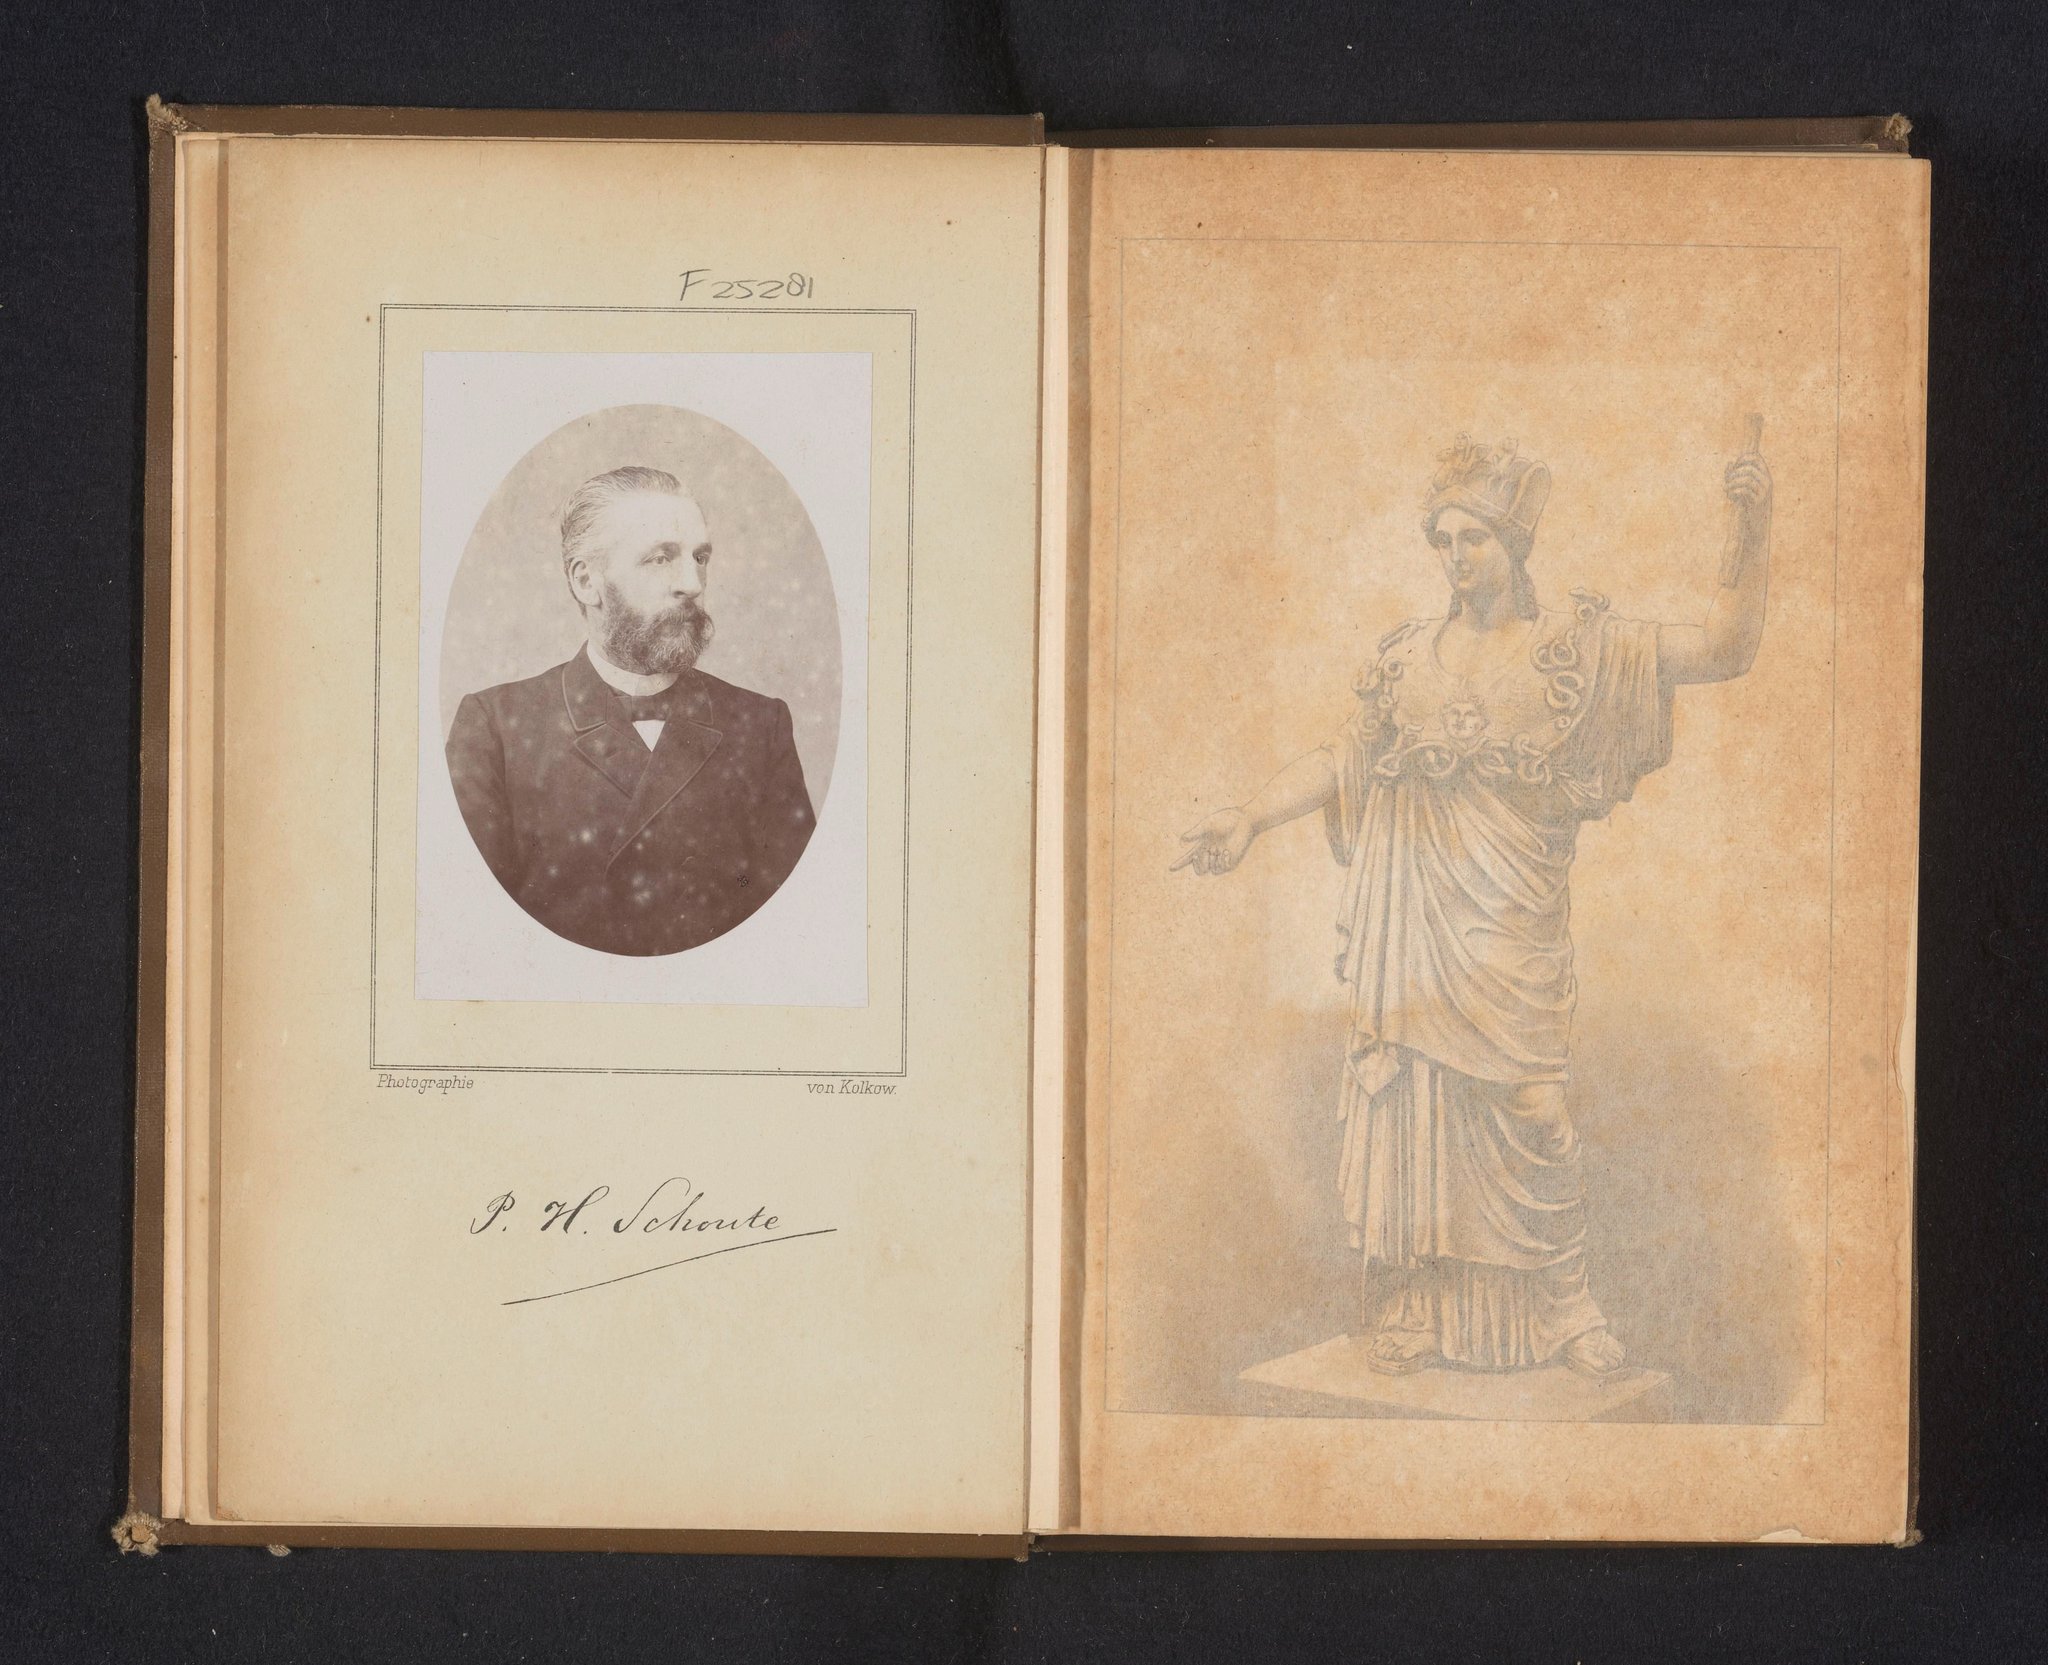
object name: page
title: Portret van Pieter Hendrik Schoute, hoogleraar wis- en natuurkunde in Groningen en rector magnificus van 1892 tot 1893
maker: friedrich julius von kolkow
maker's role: fotograaf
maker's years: 1839-1914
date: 1888-1893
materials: photographic support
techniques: collodion silver print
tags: historical persons, professor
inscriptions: name: ‘P. H. Schoute’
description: Foto op derde ongenummerde pagina voor titelpagina.